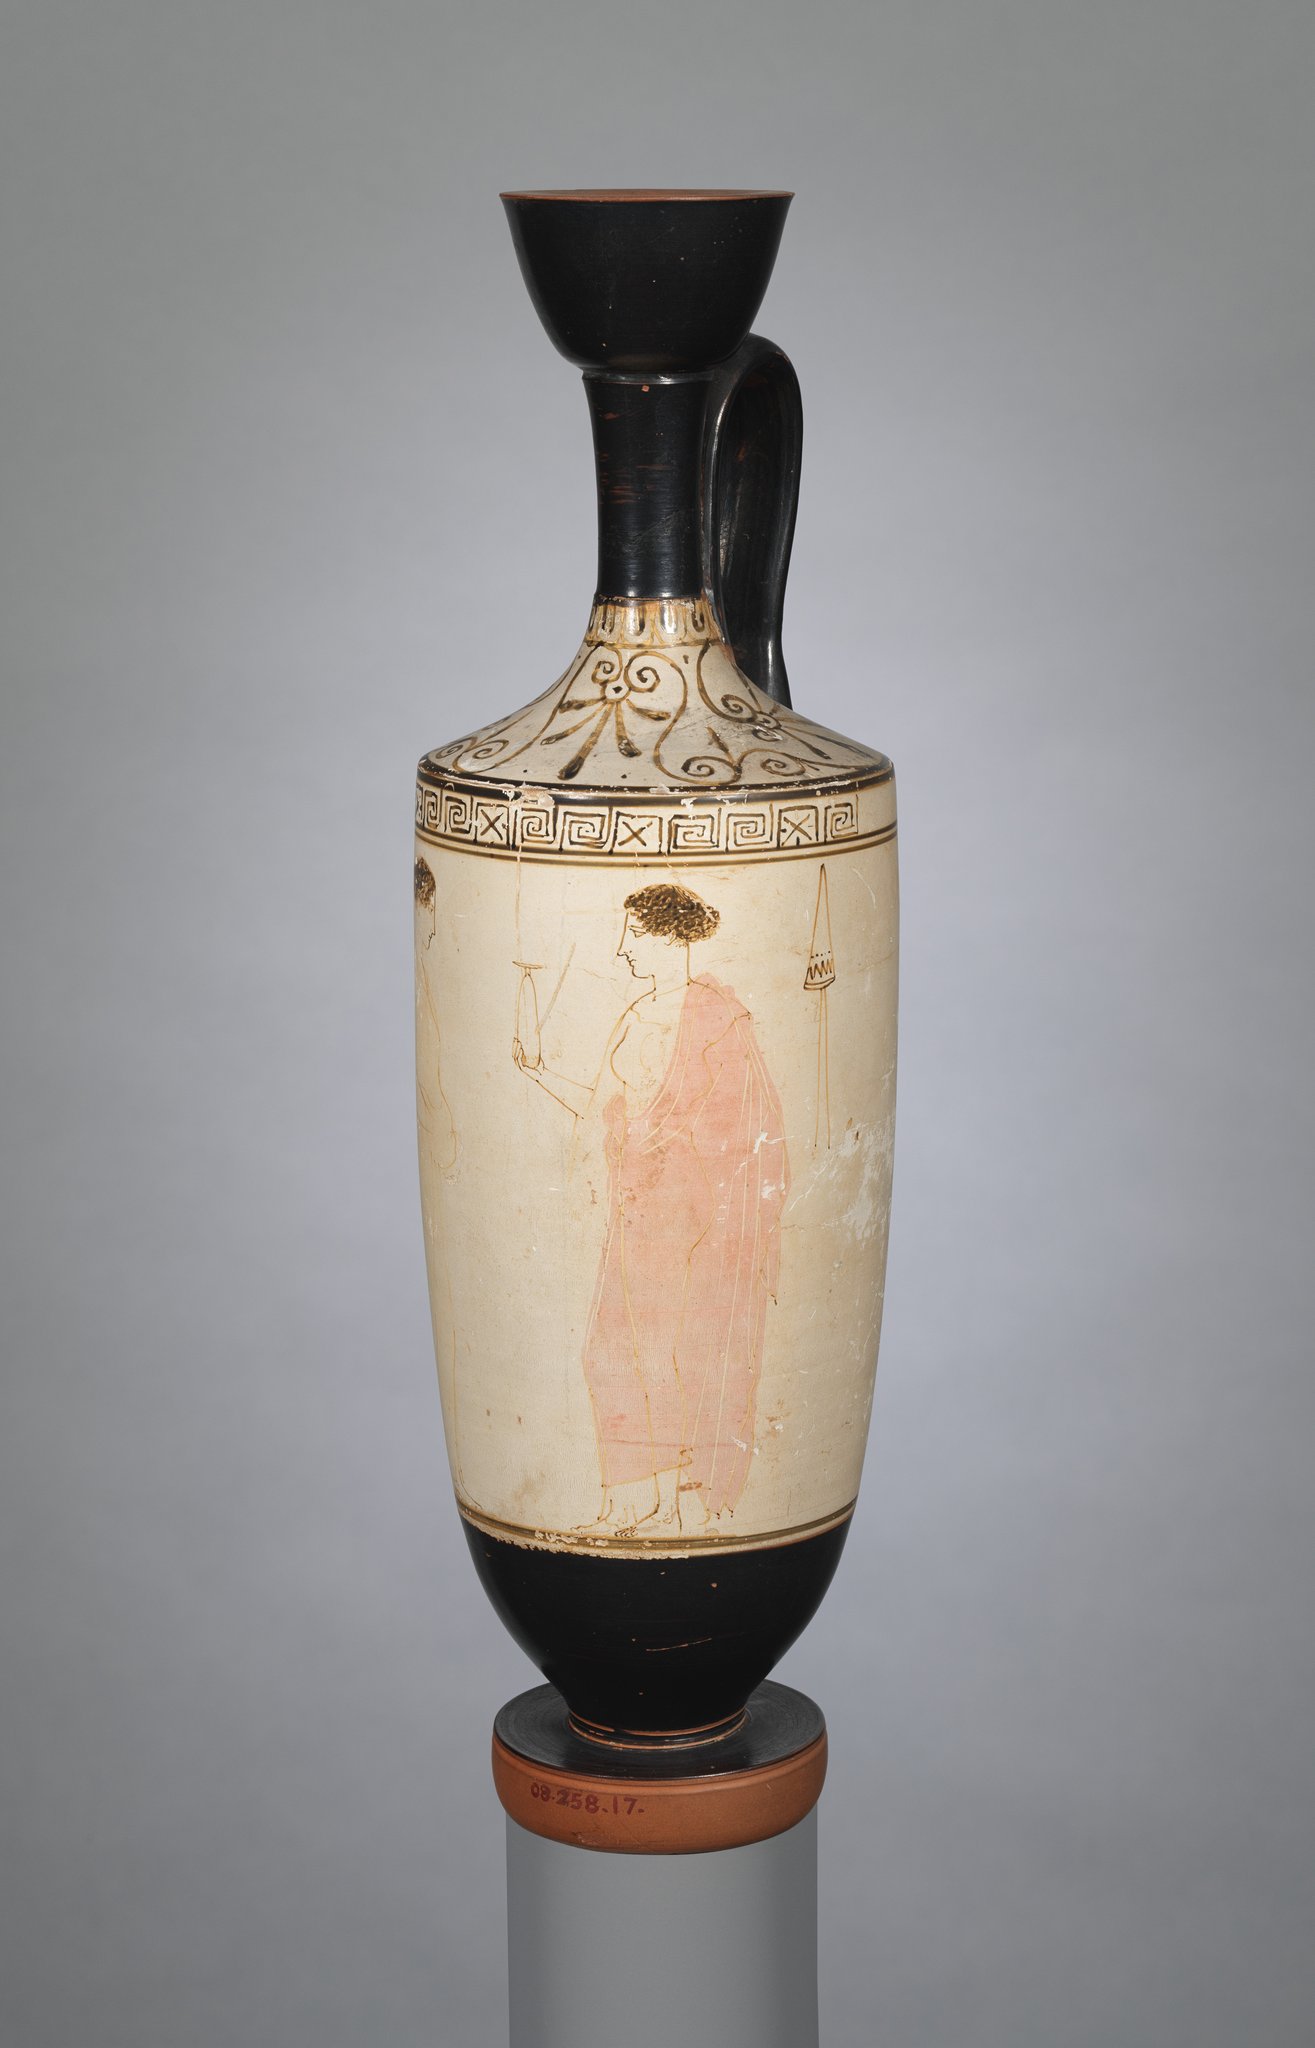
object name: lekythos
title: Terracotta lekythos (oil flask)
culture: greek, attic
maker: achilles painter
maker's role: artist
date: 440 BCE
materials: terracotta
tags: women